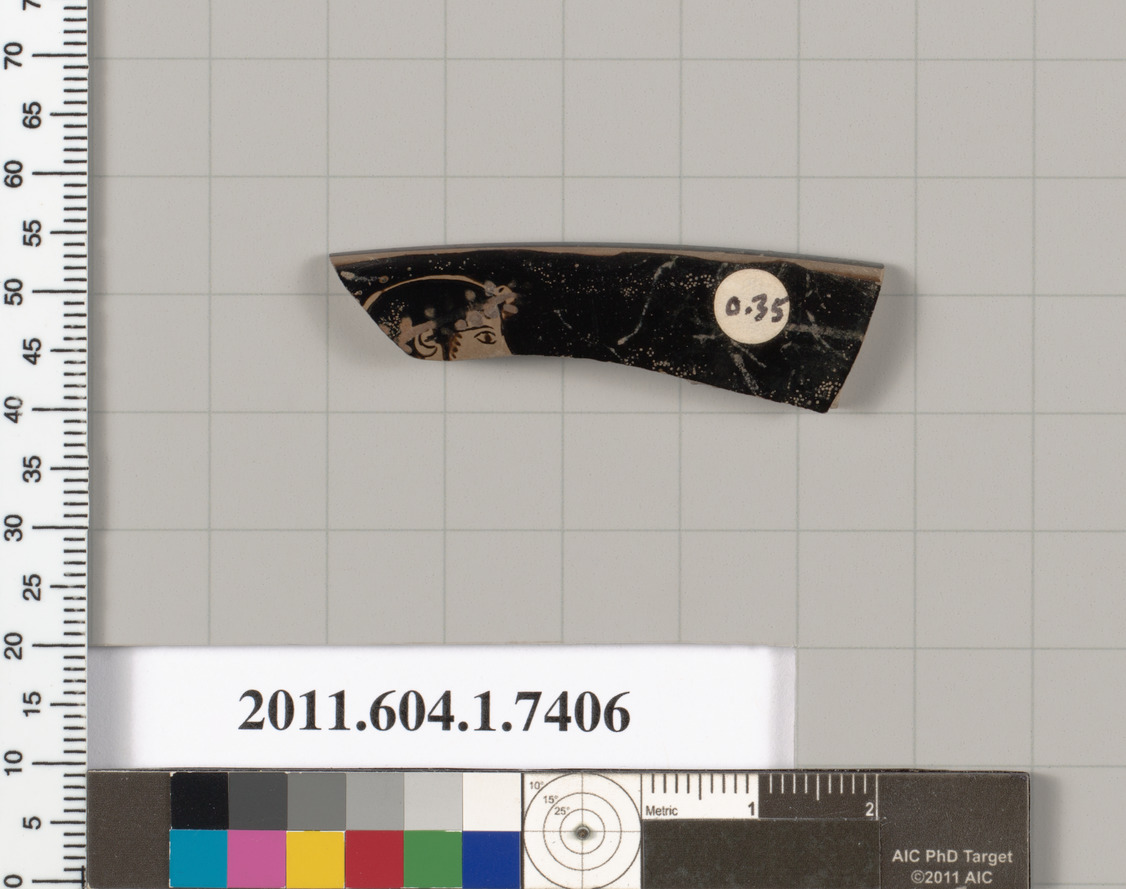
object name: kylix fragment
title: Terracotta rim fragment of a kylix (drinking cup)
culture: greek, attic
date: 490-470 BCE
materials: terracotta